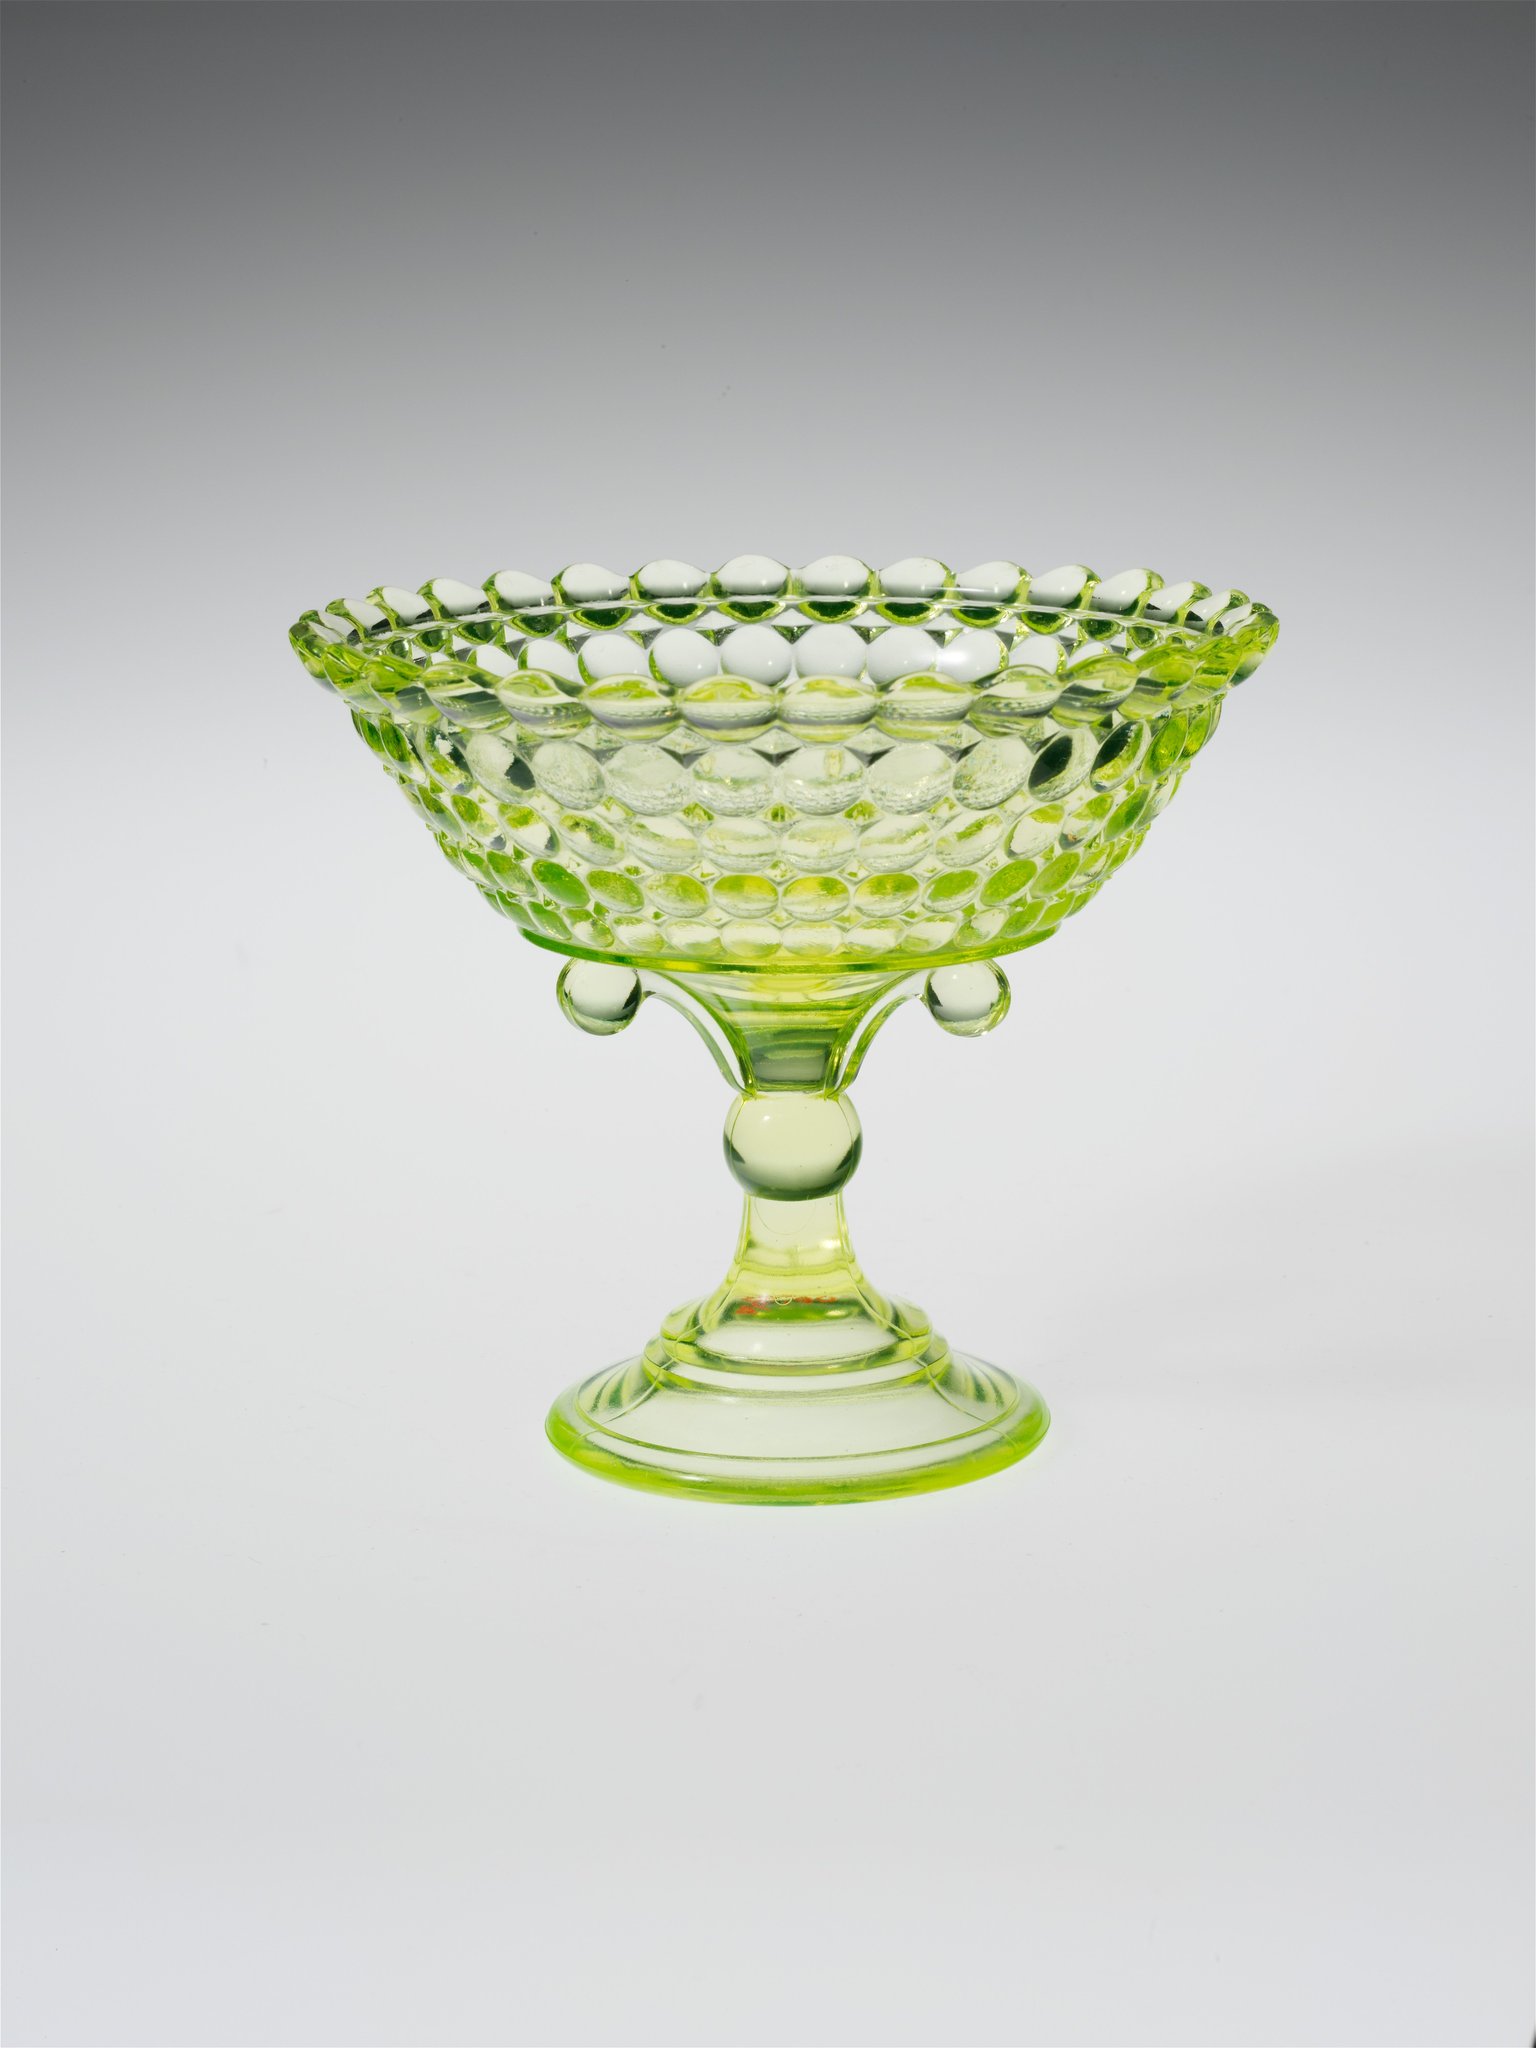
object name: compote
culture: american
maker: adams and company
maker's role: maker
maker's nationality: american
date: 1870-1890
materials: glass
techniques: pressed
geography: united states